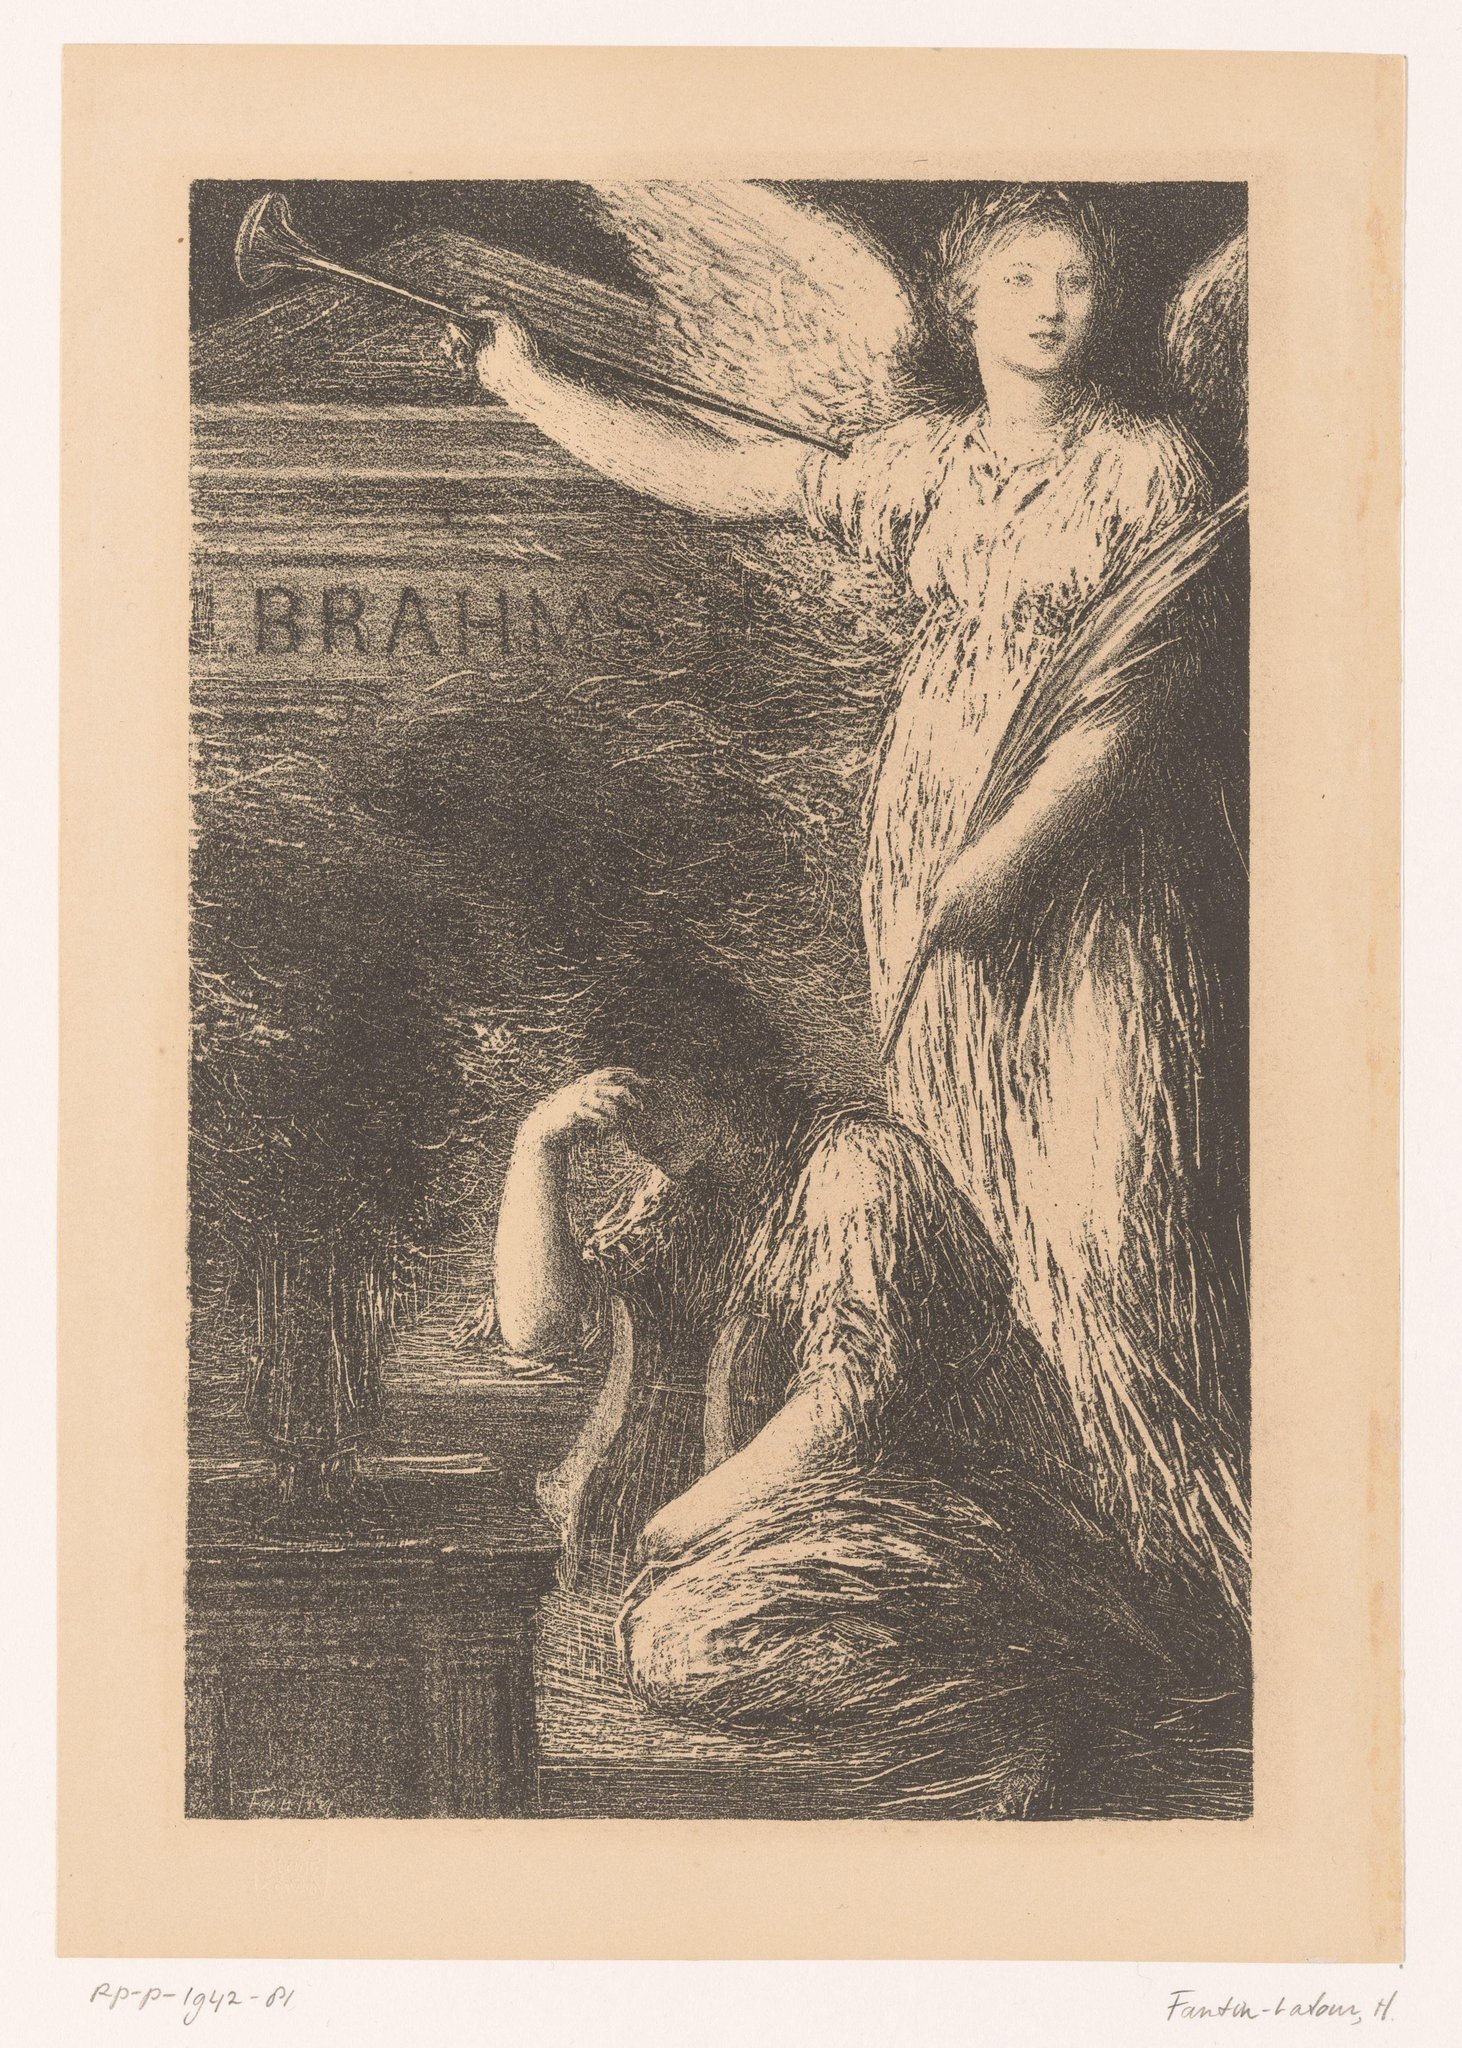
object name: print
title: Muziek en Roem bij een mausoleum voor Brahms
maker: henri fantin-latour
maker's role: draughtsman, print maker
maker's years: 1836-1904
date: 1898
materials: paper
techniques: lithography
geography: paris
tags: commemoration of an artist, 'musica', symbolic representations, allegories and emblems ~ music; 'musica'(ripa) - cc - out of doors, fame; 'fama', 'fama buona', 'fama chiara' (ripa) (+ personification), mausoleum, grave-building, monumental tomb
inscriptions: collector's mark: Lugt 2760, collector's mark: Lugt 2228a, check stamp: Lugt 2322bis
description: Prent gebruikt voor: The Studio, numéro des Salons de Paris, 1898.